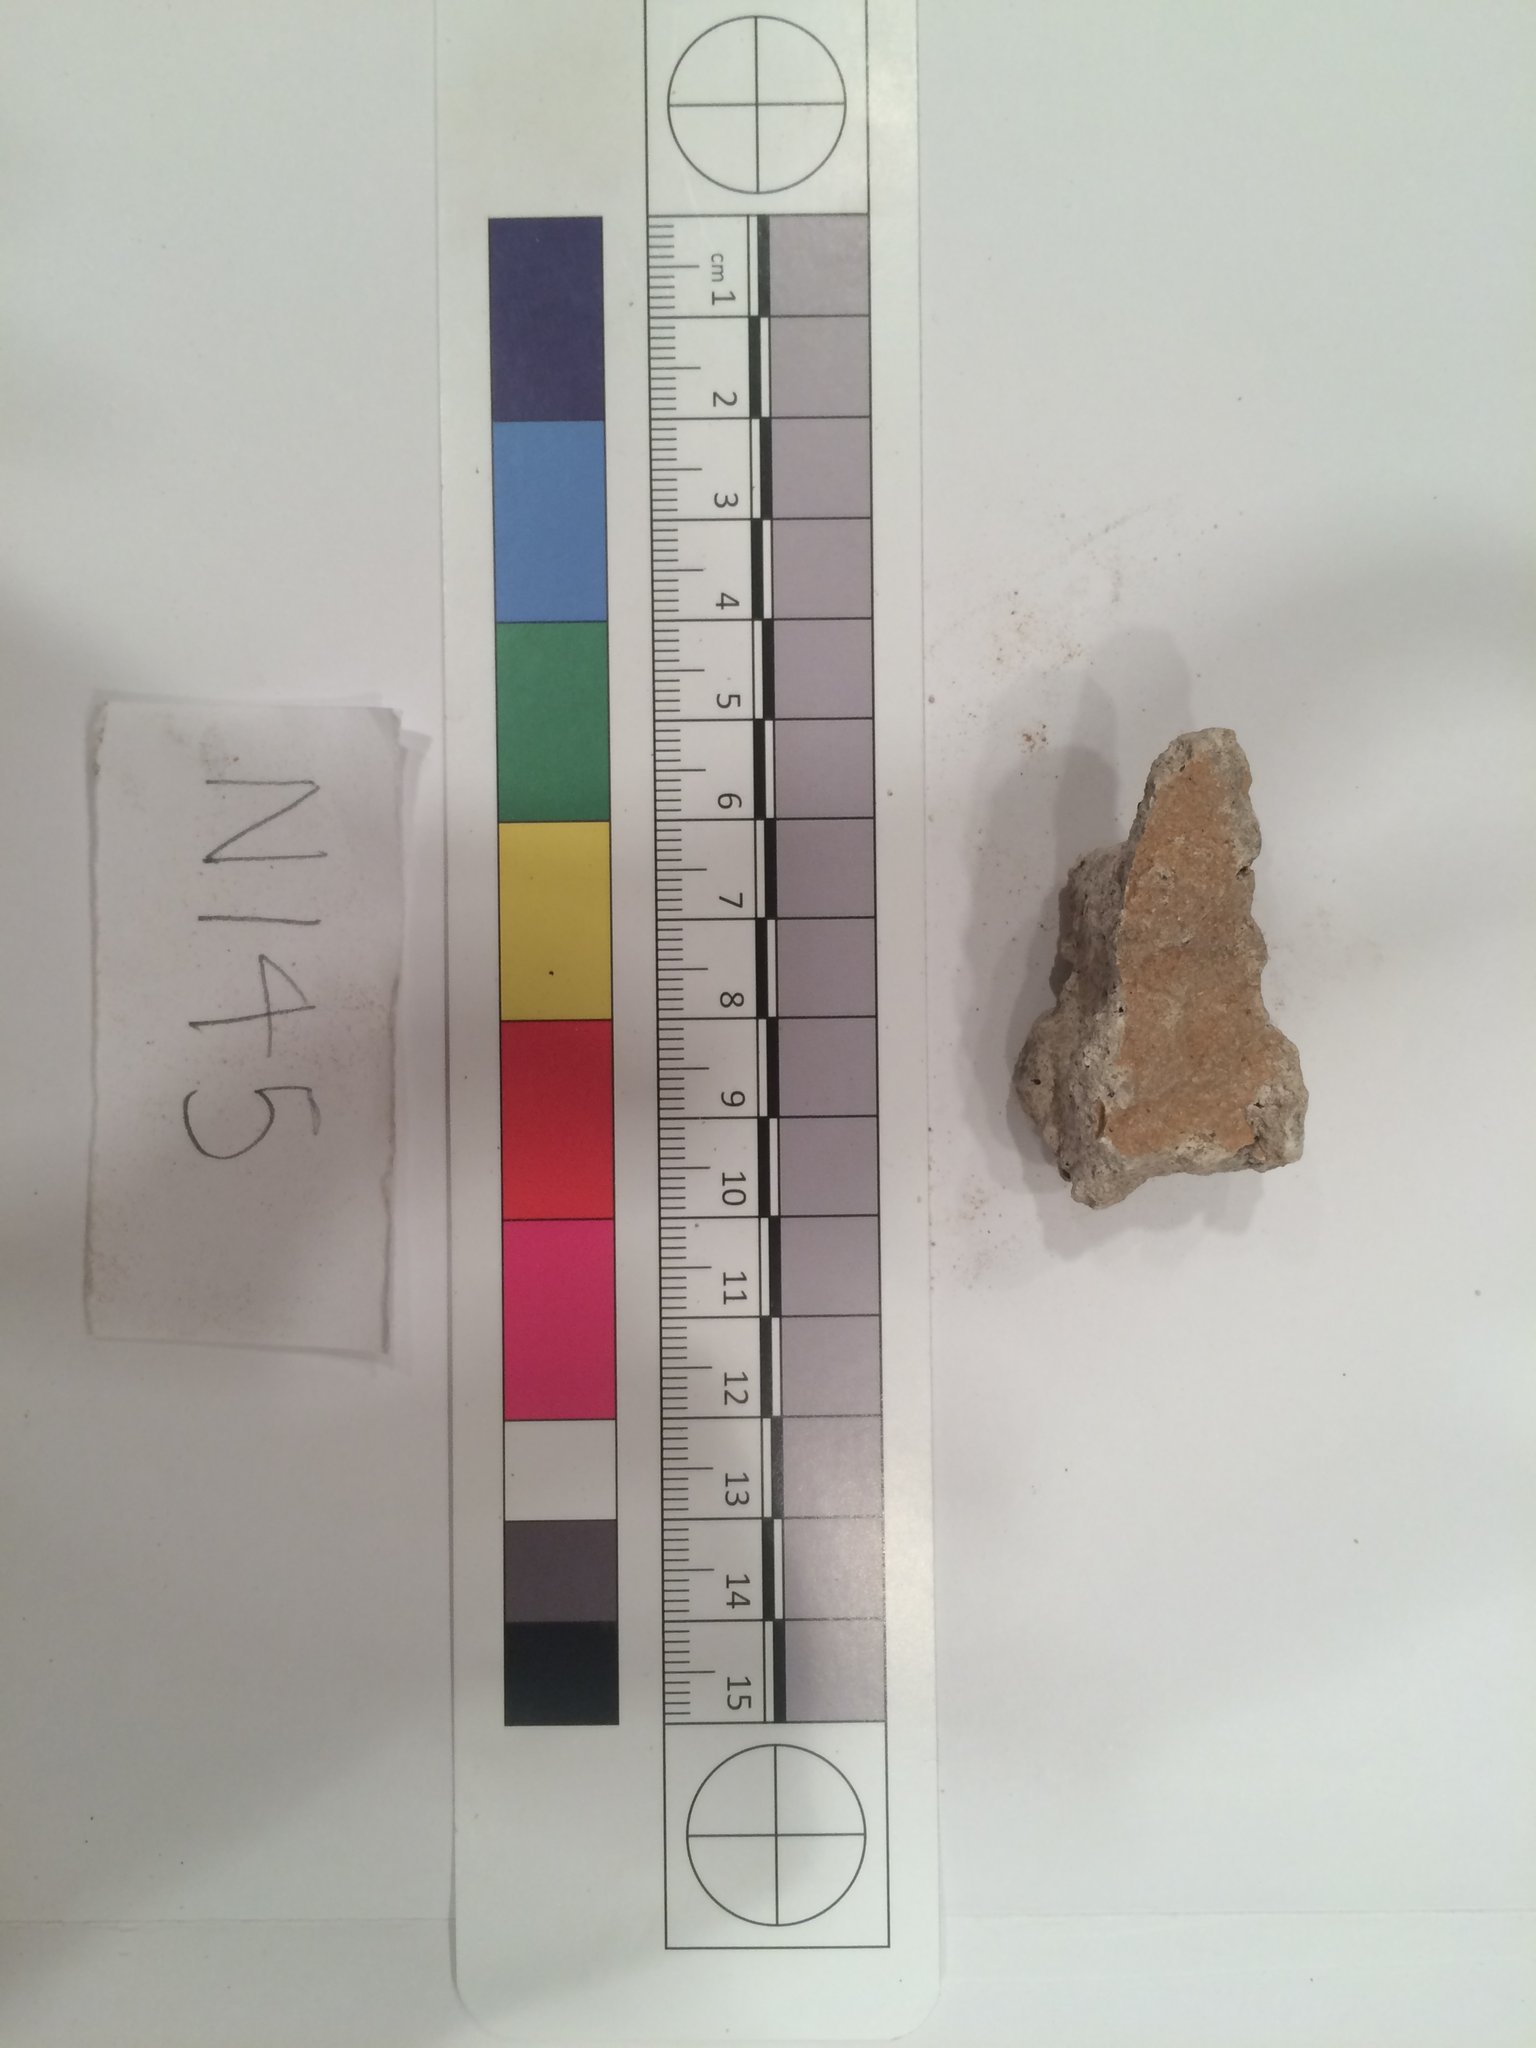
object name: fragment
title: Stucco Fragment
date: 701-1200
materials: plaster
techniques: carving, painting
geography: iran